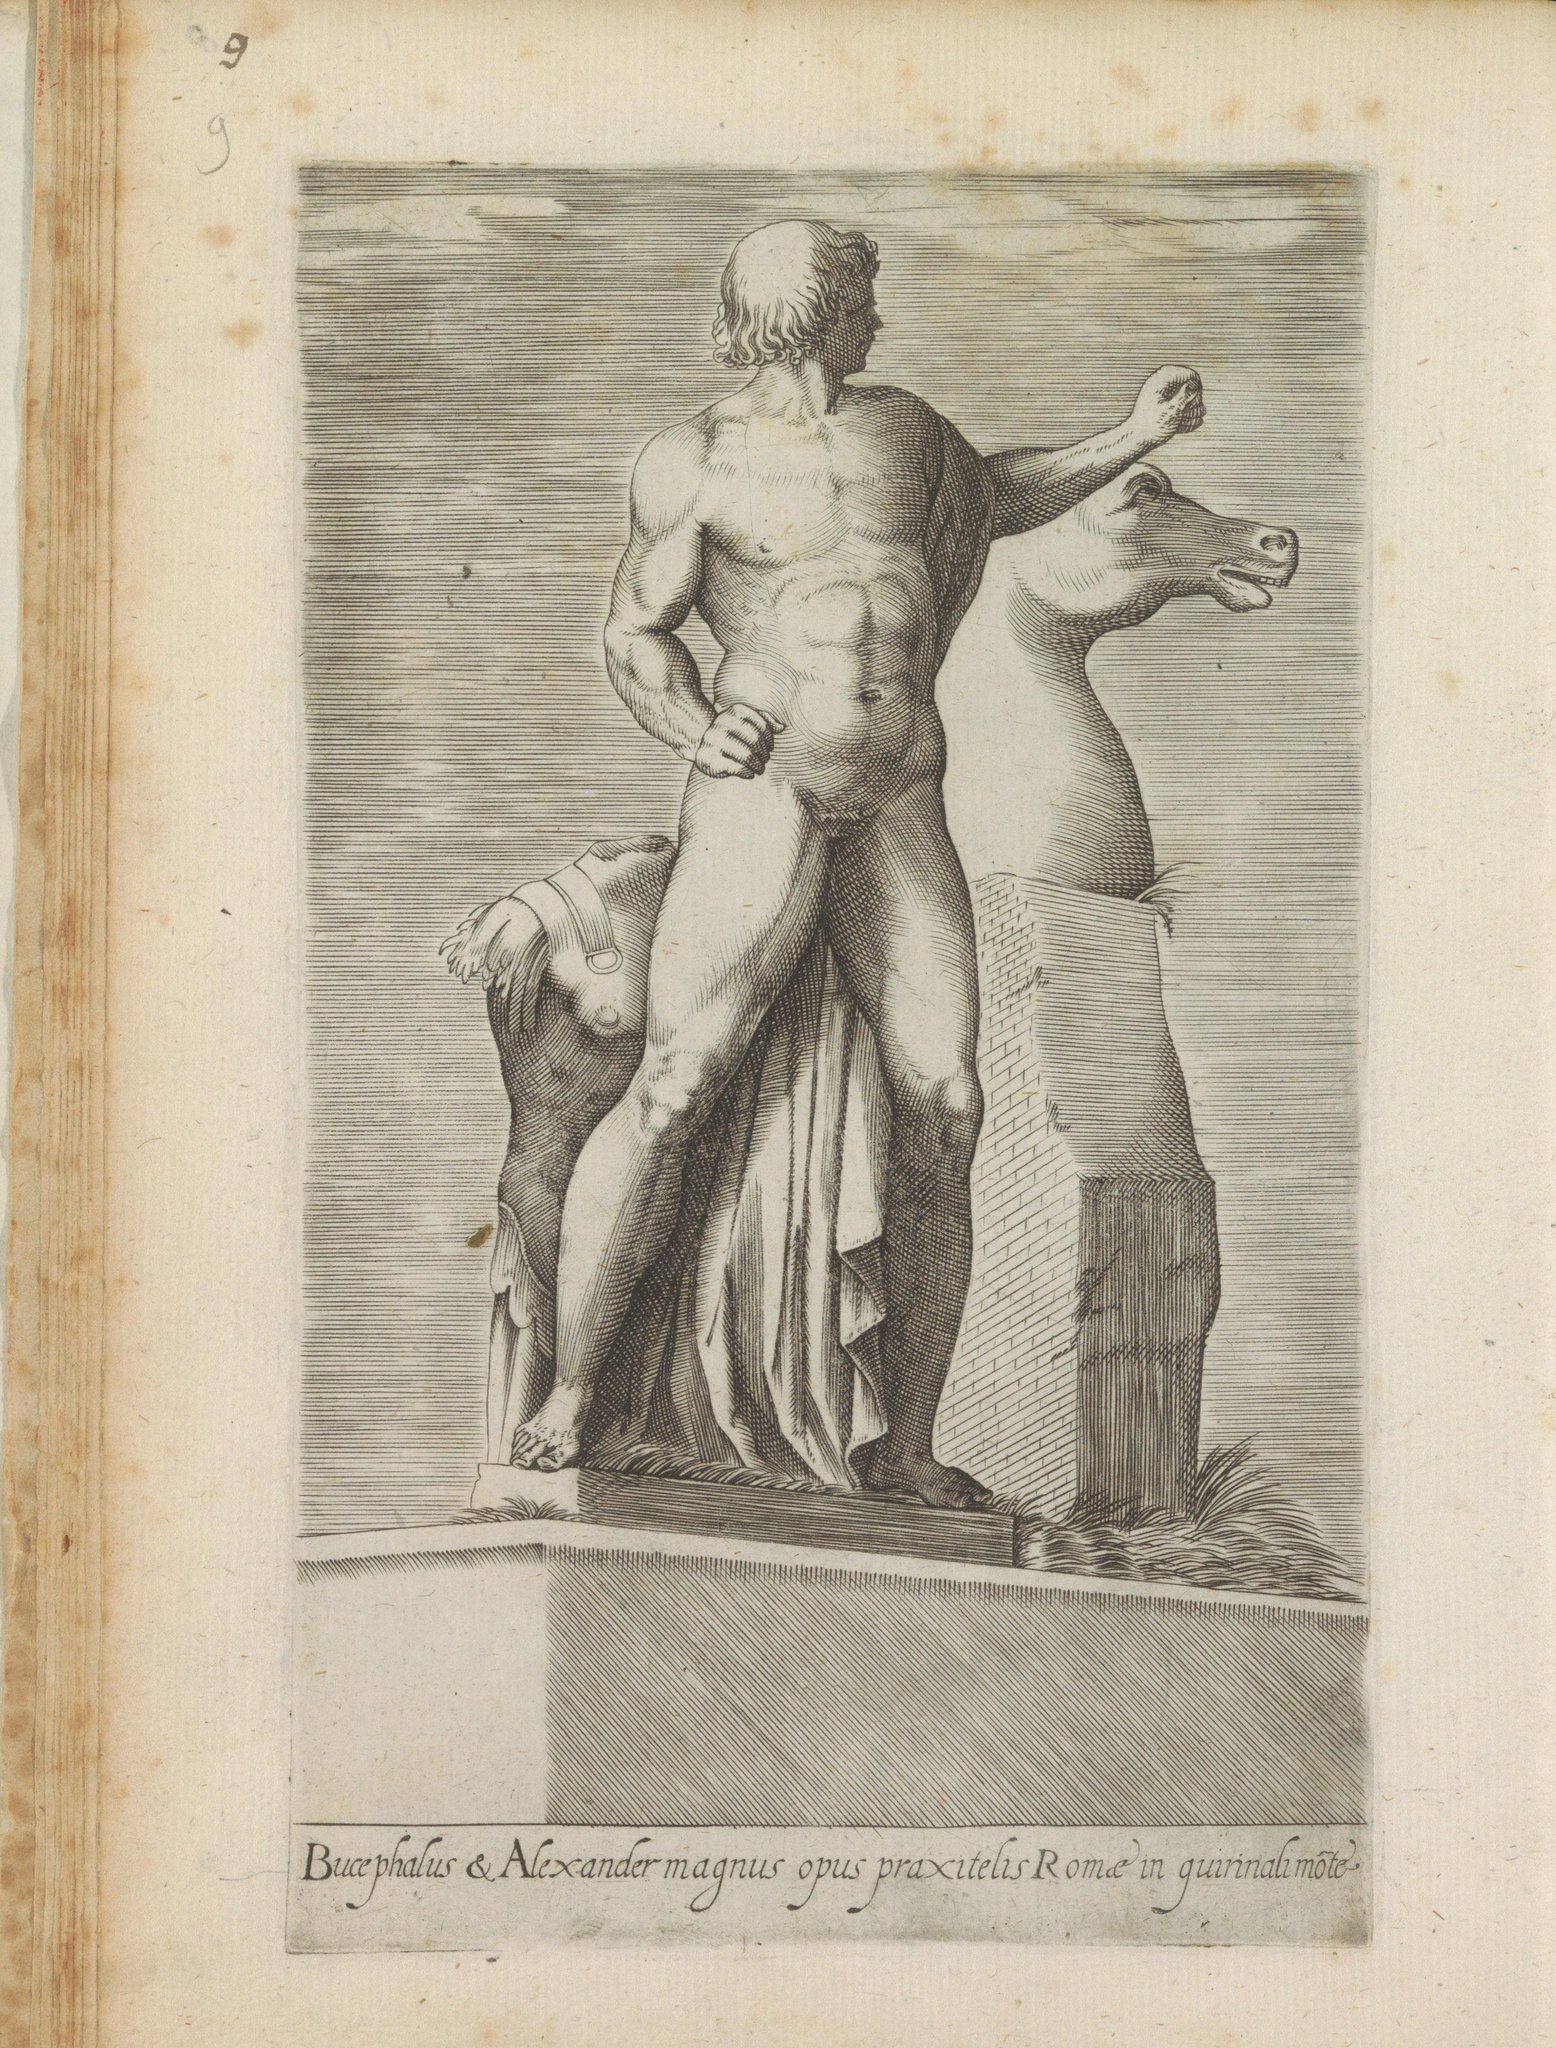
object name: print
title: Antieke sculpturen in Rome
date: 1584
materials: paper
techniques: engraving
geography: italy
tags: piece of sculpture, reproduction of a piece of sculpture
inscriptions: number: ‘9’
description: Een van de twee standbeelden van de Dioscuren (Castor en Pollux), twee naakte mannen met paarden. Voorheen geïnterpreteerd als de kunstenaars Pheidias en Praxiteles. De beelden staan op het Piazza del Quirinale in Rome. Onderschrift in het Latijn. Prent maakt deel uit van een album.